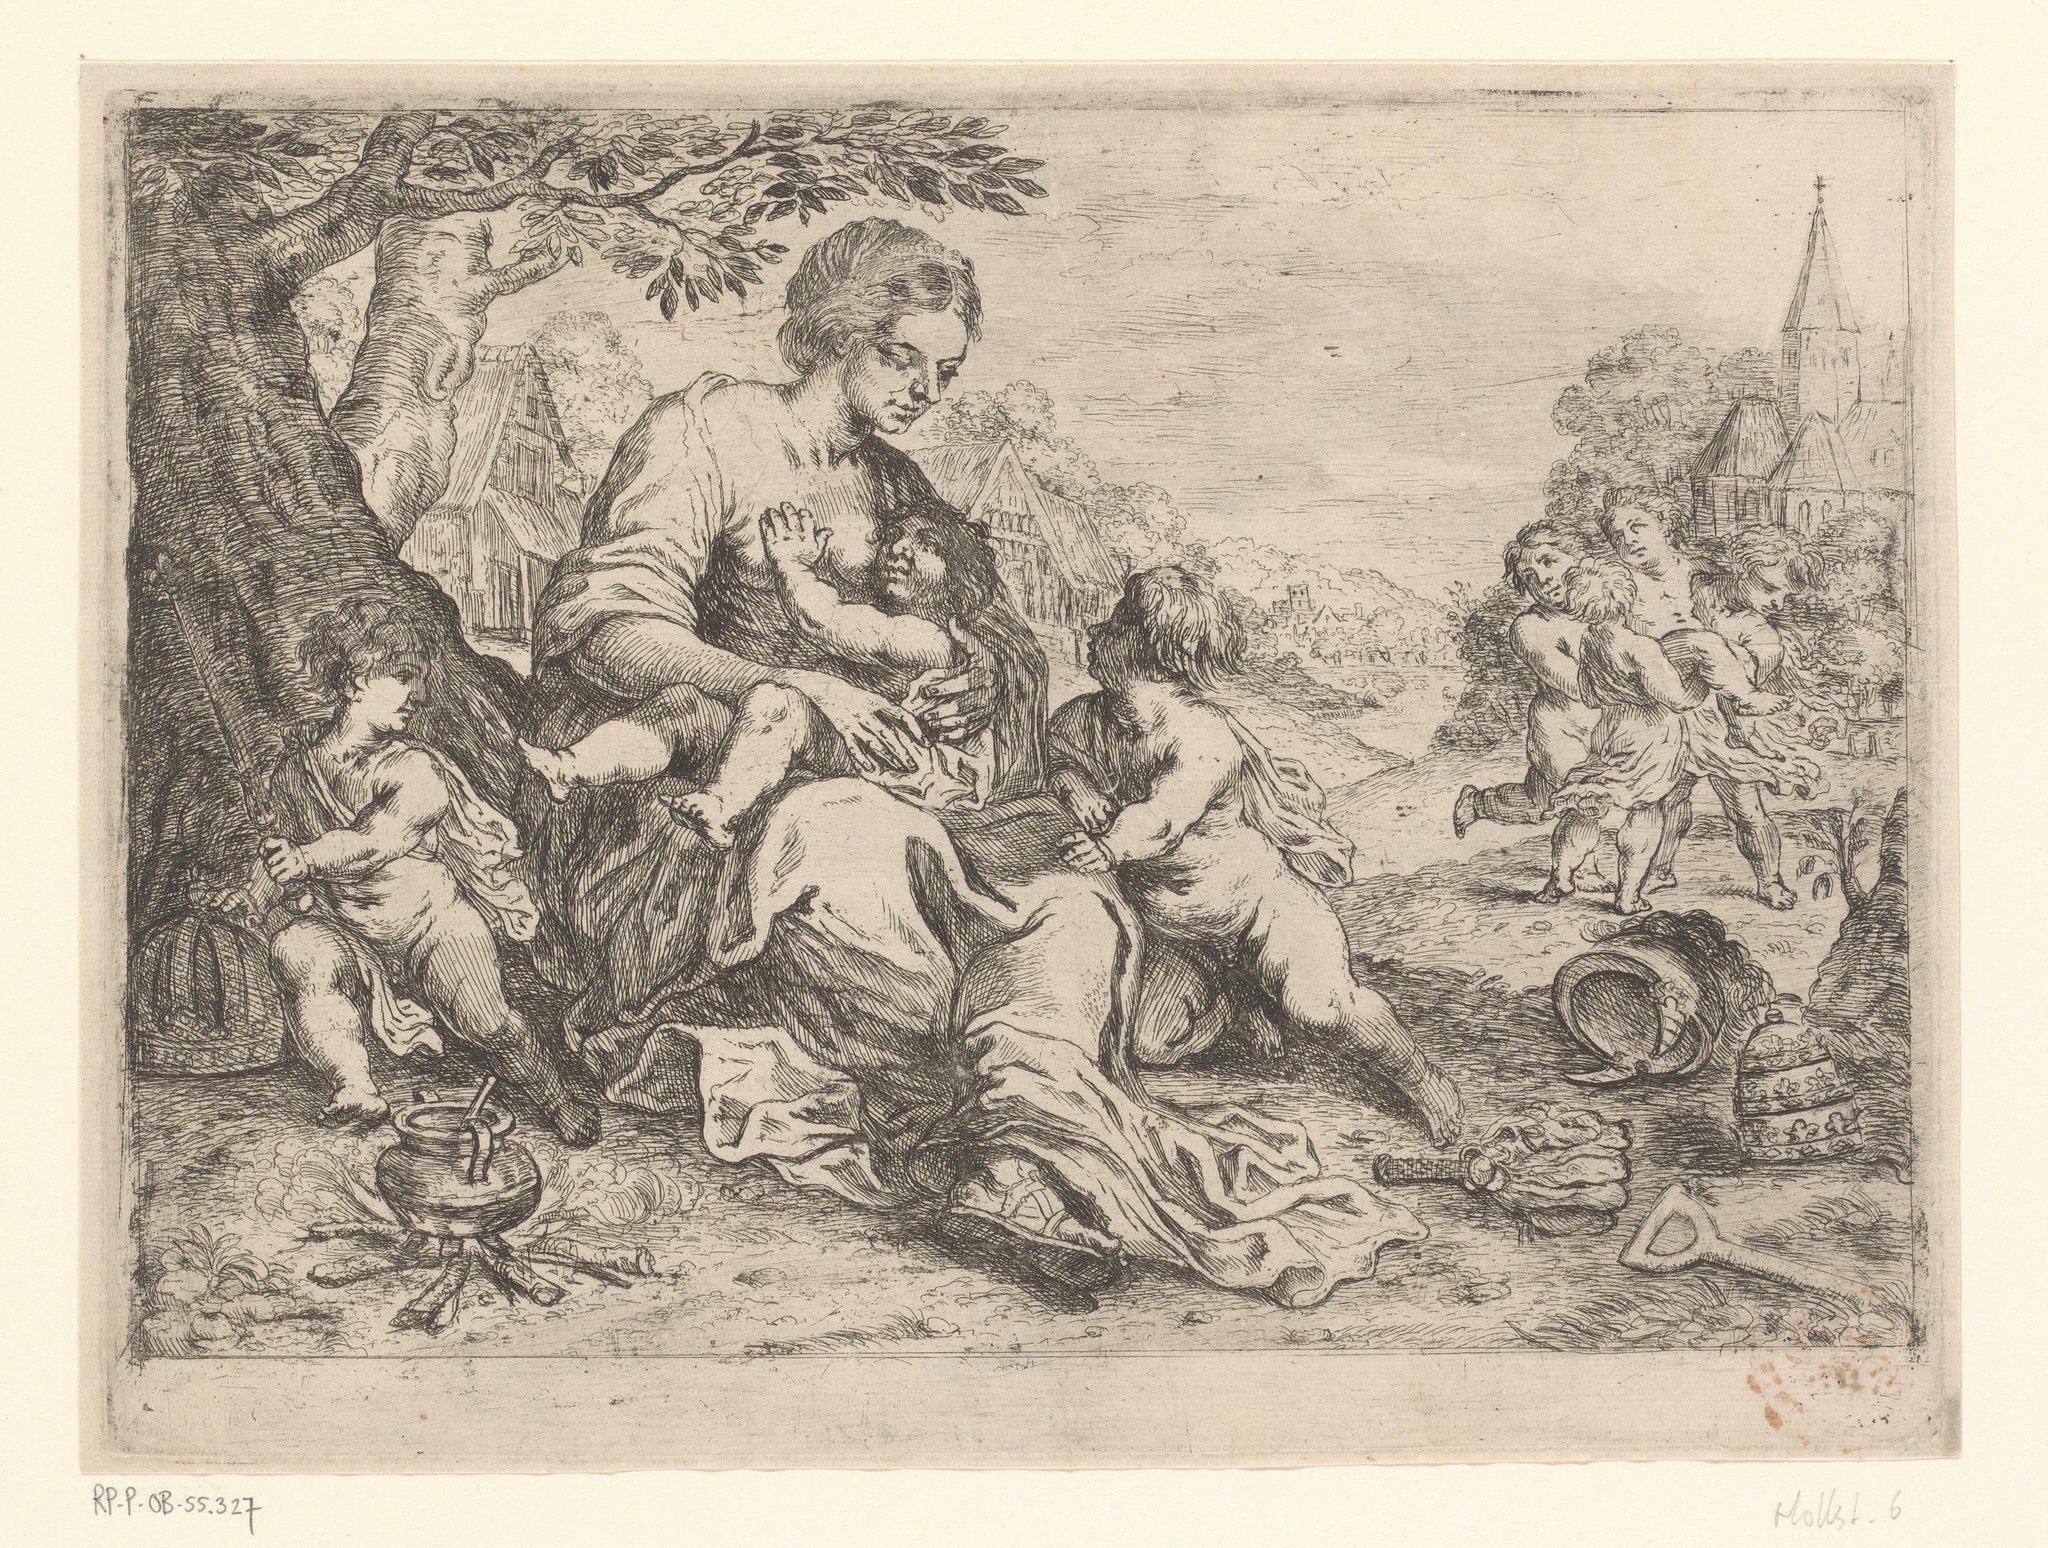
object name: print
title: Moeder met kinderen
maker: hendrick heerschop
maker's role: painter, print maker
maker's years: 1626-1690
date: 1636-1690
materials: paper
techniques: etching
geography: northern netherlands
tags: crown (symbol of sovereignty), sceptre, staff (symbol of sovereignty), insignia of the pope, e.g. tiara, mother and baby or young child, infant, baby ~ the ages of man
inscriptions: collector's mark: Lugt 240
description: Een vrouw, zittend onder een boom, heeft een kind aan de borst. Aan weerskanten van haar twee andere kinderen, waarvan één een scepter en een kroon vasthoudt. Rechts op de grond liggen een helm en een pauselijke tiara. Links op de voorgrond staat een pot op het vuur. Op de achtergrond drie andere kinderen die een vierde kind dragen.